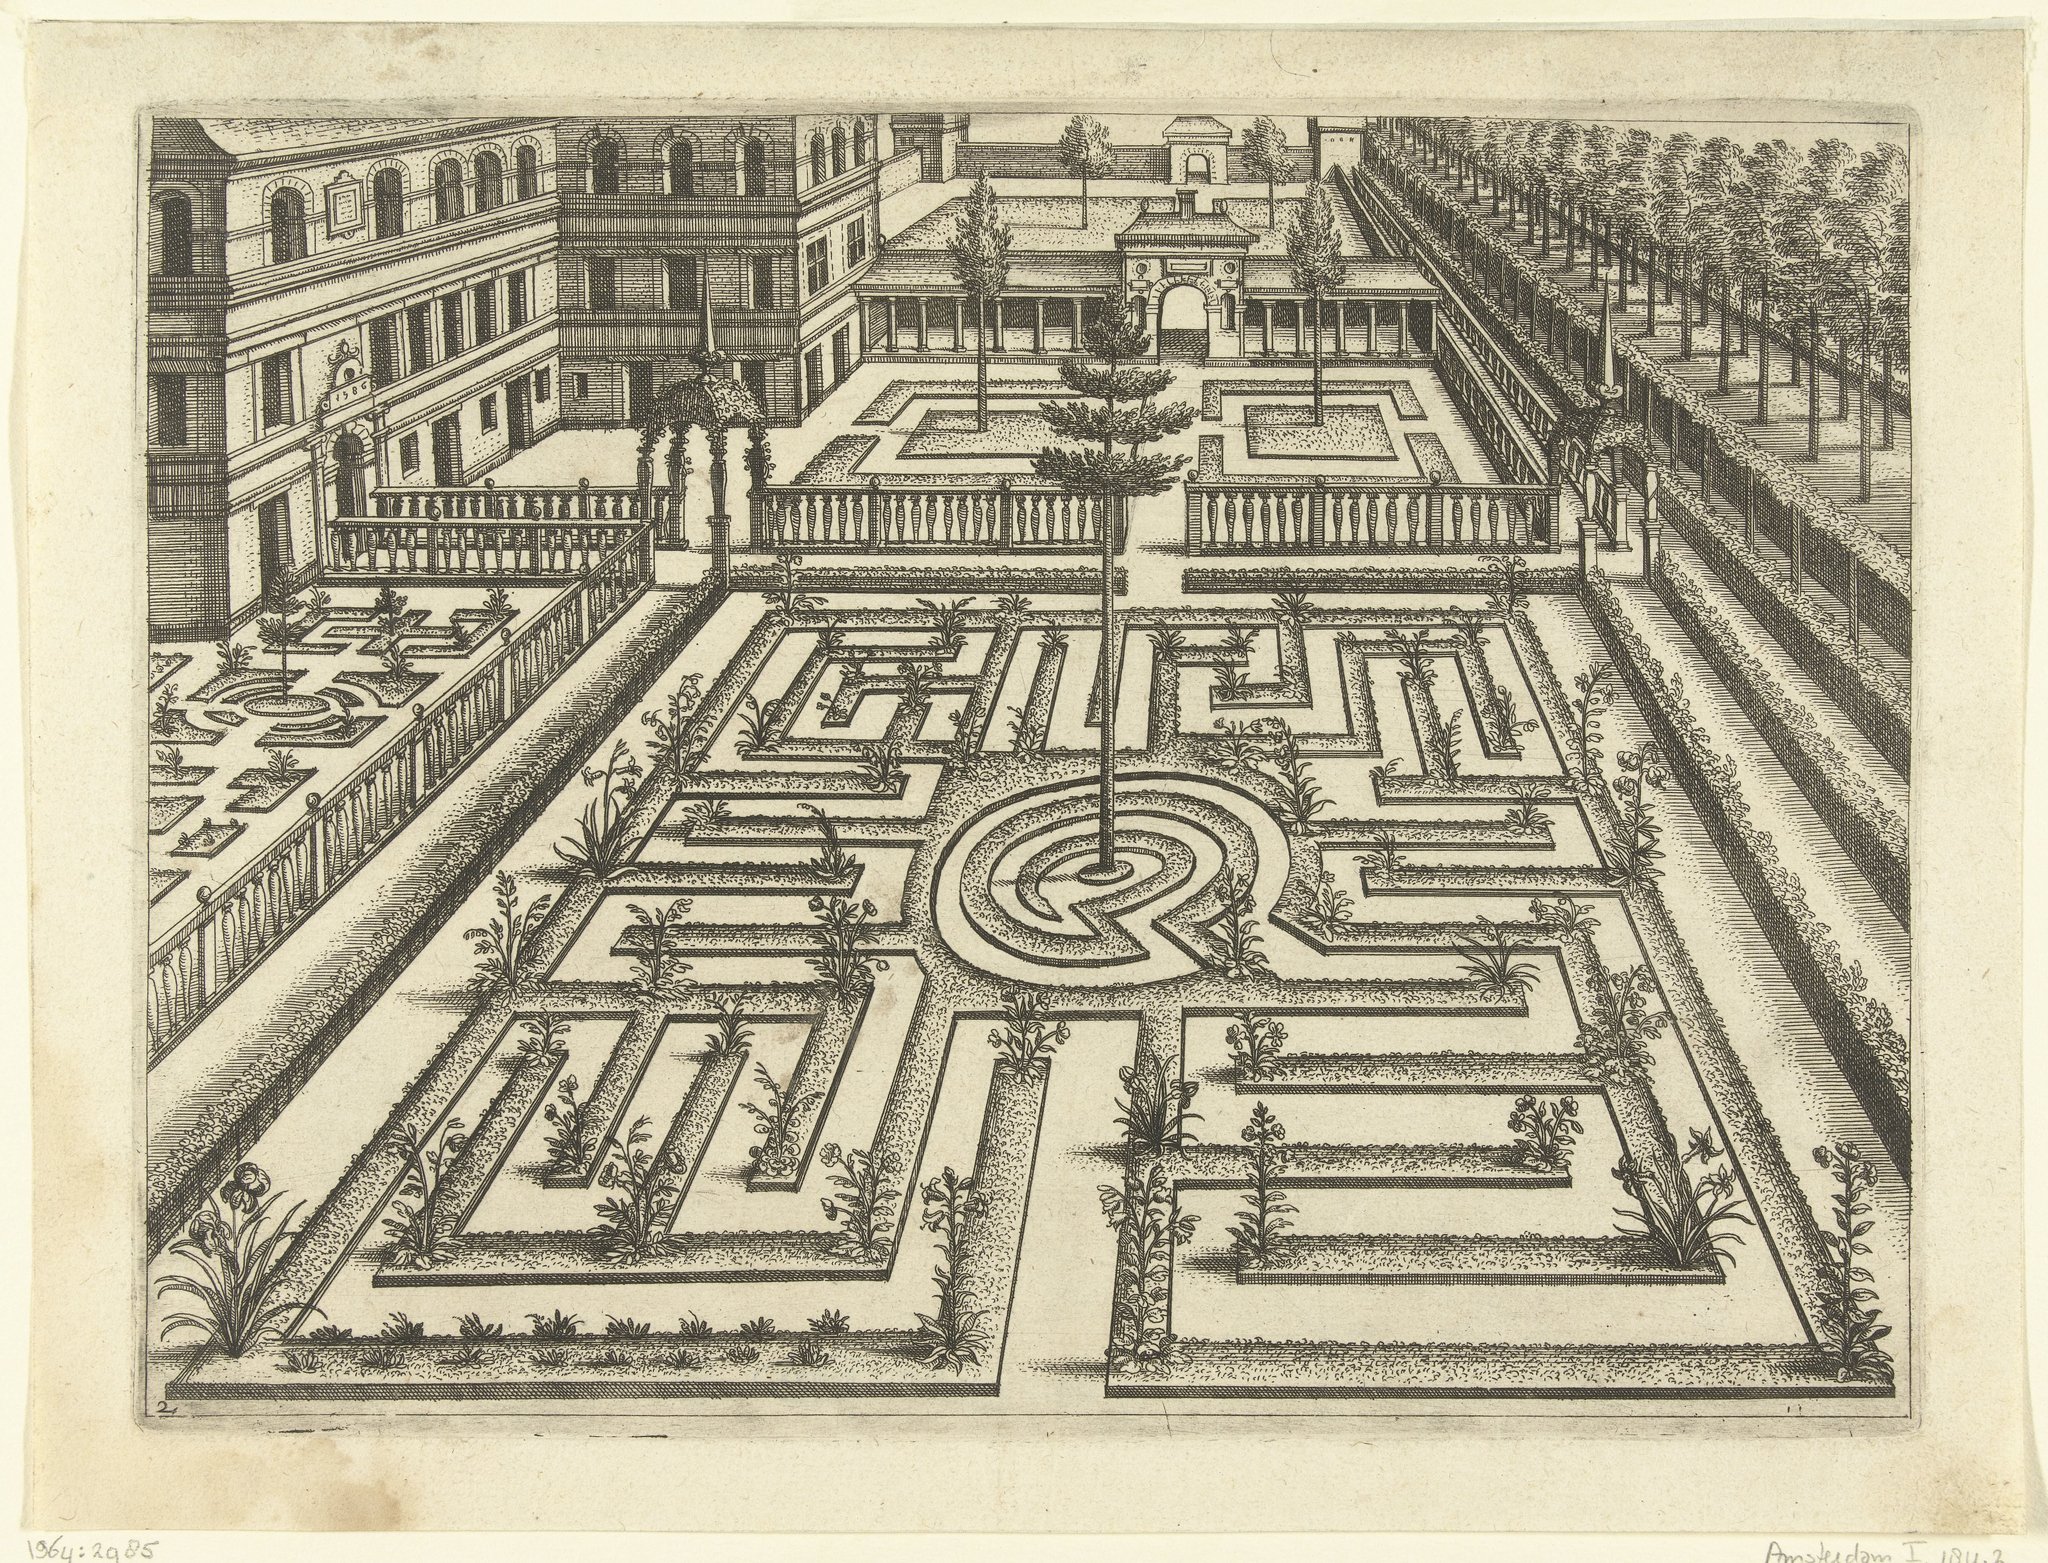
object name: print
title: Tuinen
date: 1587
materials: paper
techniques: etching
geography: netherlands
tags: garden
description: Een tuin met een parterre. In het midden daarvan staat een hoge boom. Blad uit serie van 8 genummerde bladen met tuinen. Op de achtergrond zijn steeds de benedenverdiepingen van gebouwen zichtbaar.